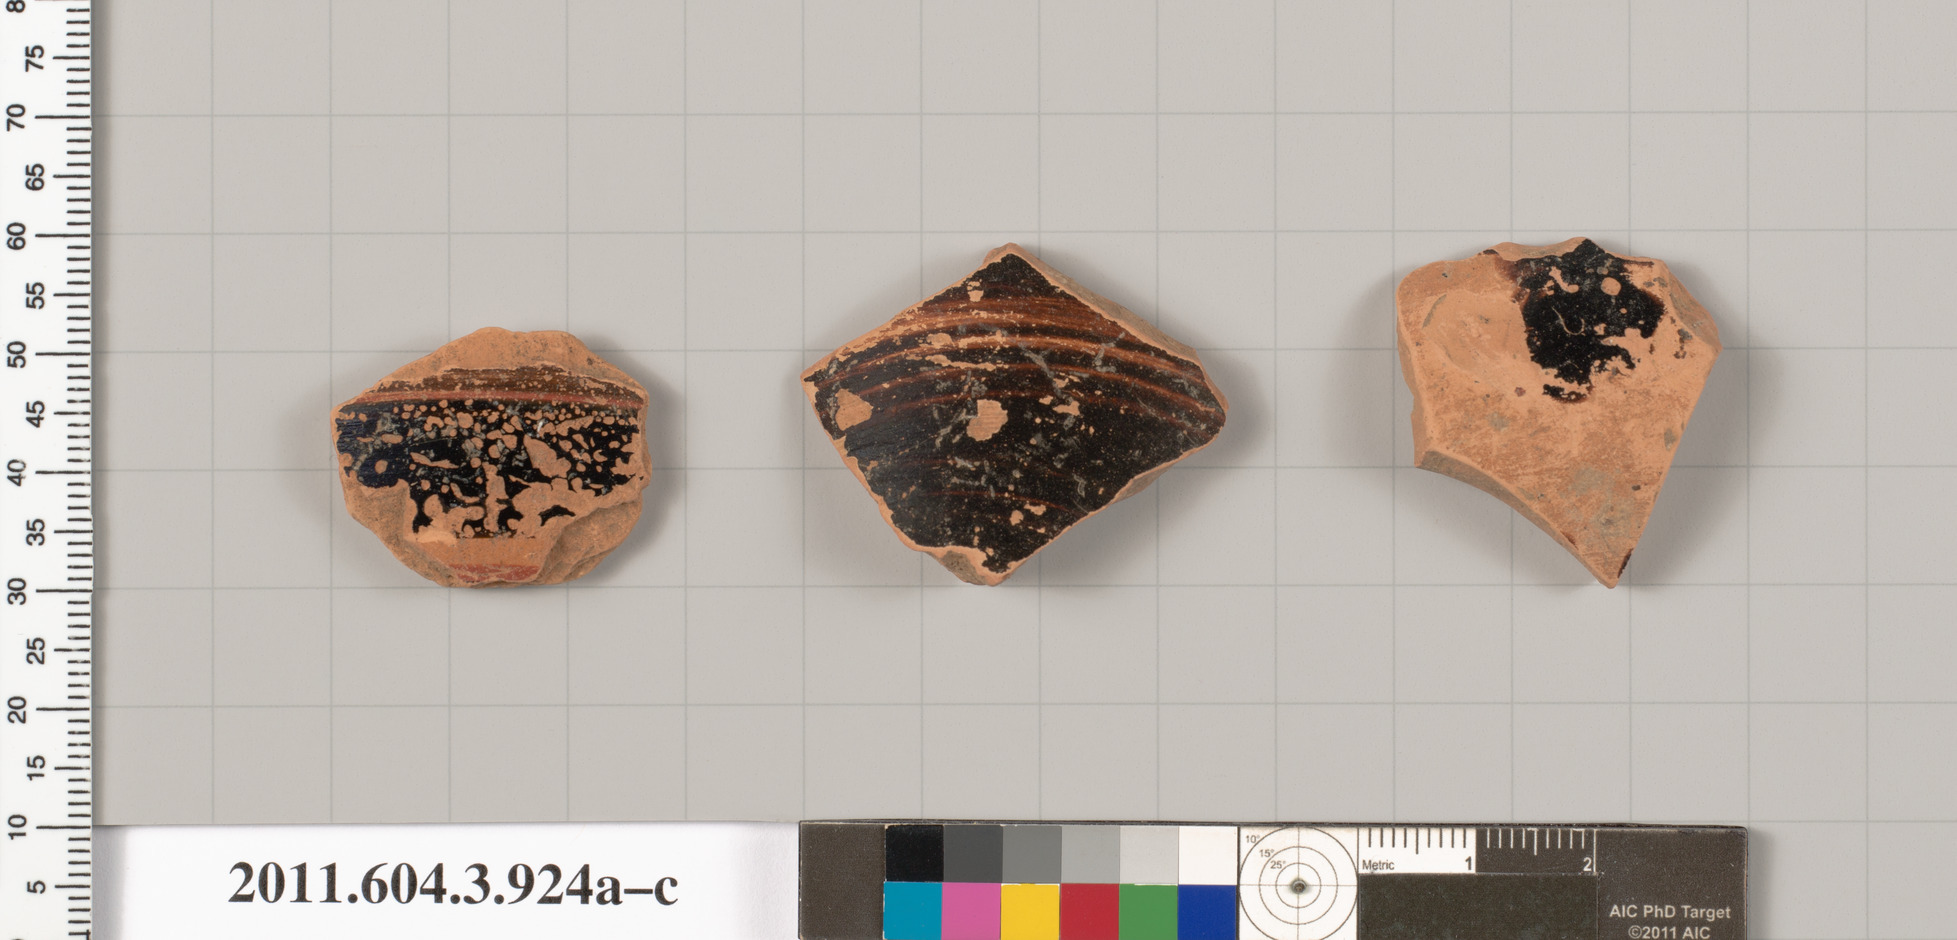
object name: lekythos fragment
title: Terracotta fragments of lekythoi (oil flasks)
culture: greek, attic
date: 600-401 BCE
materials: terracotta